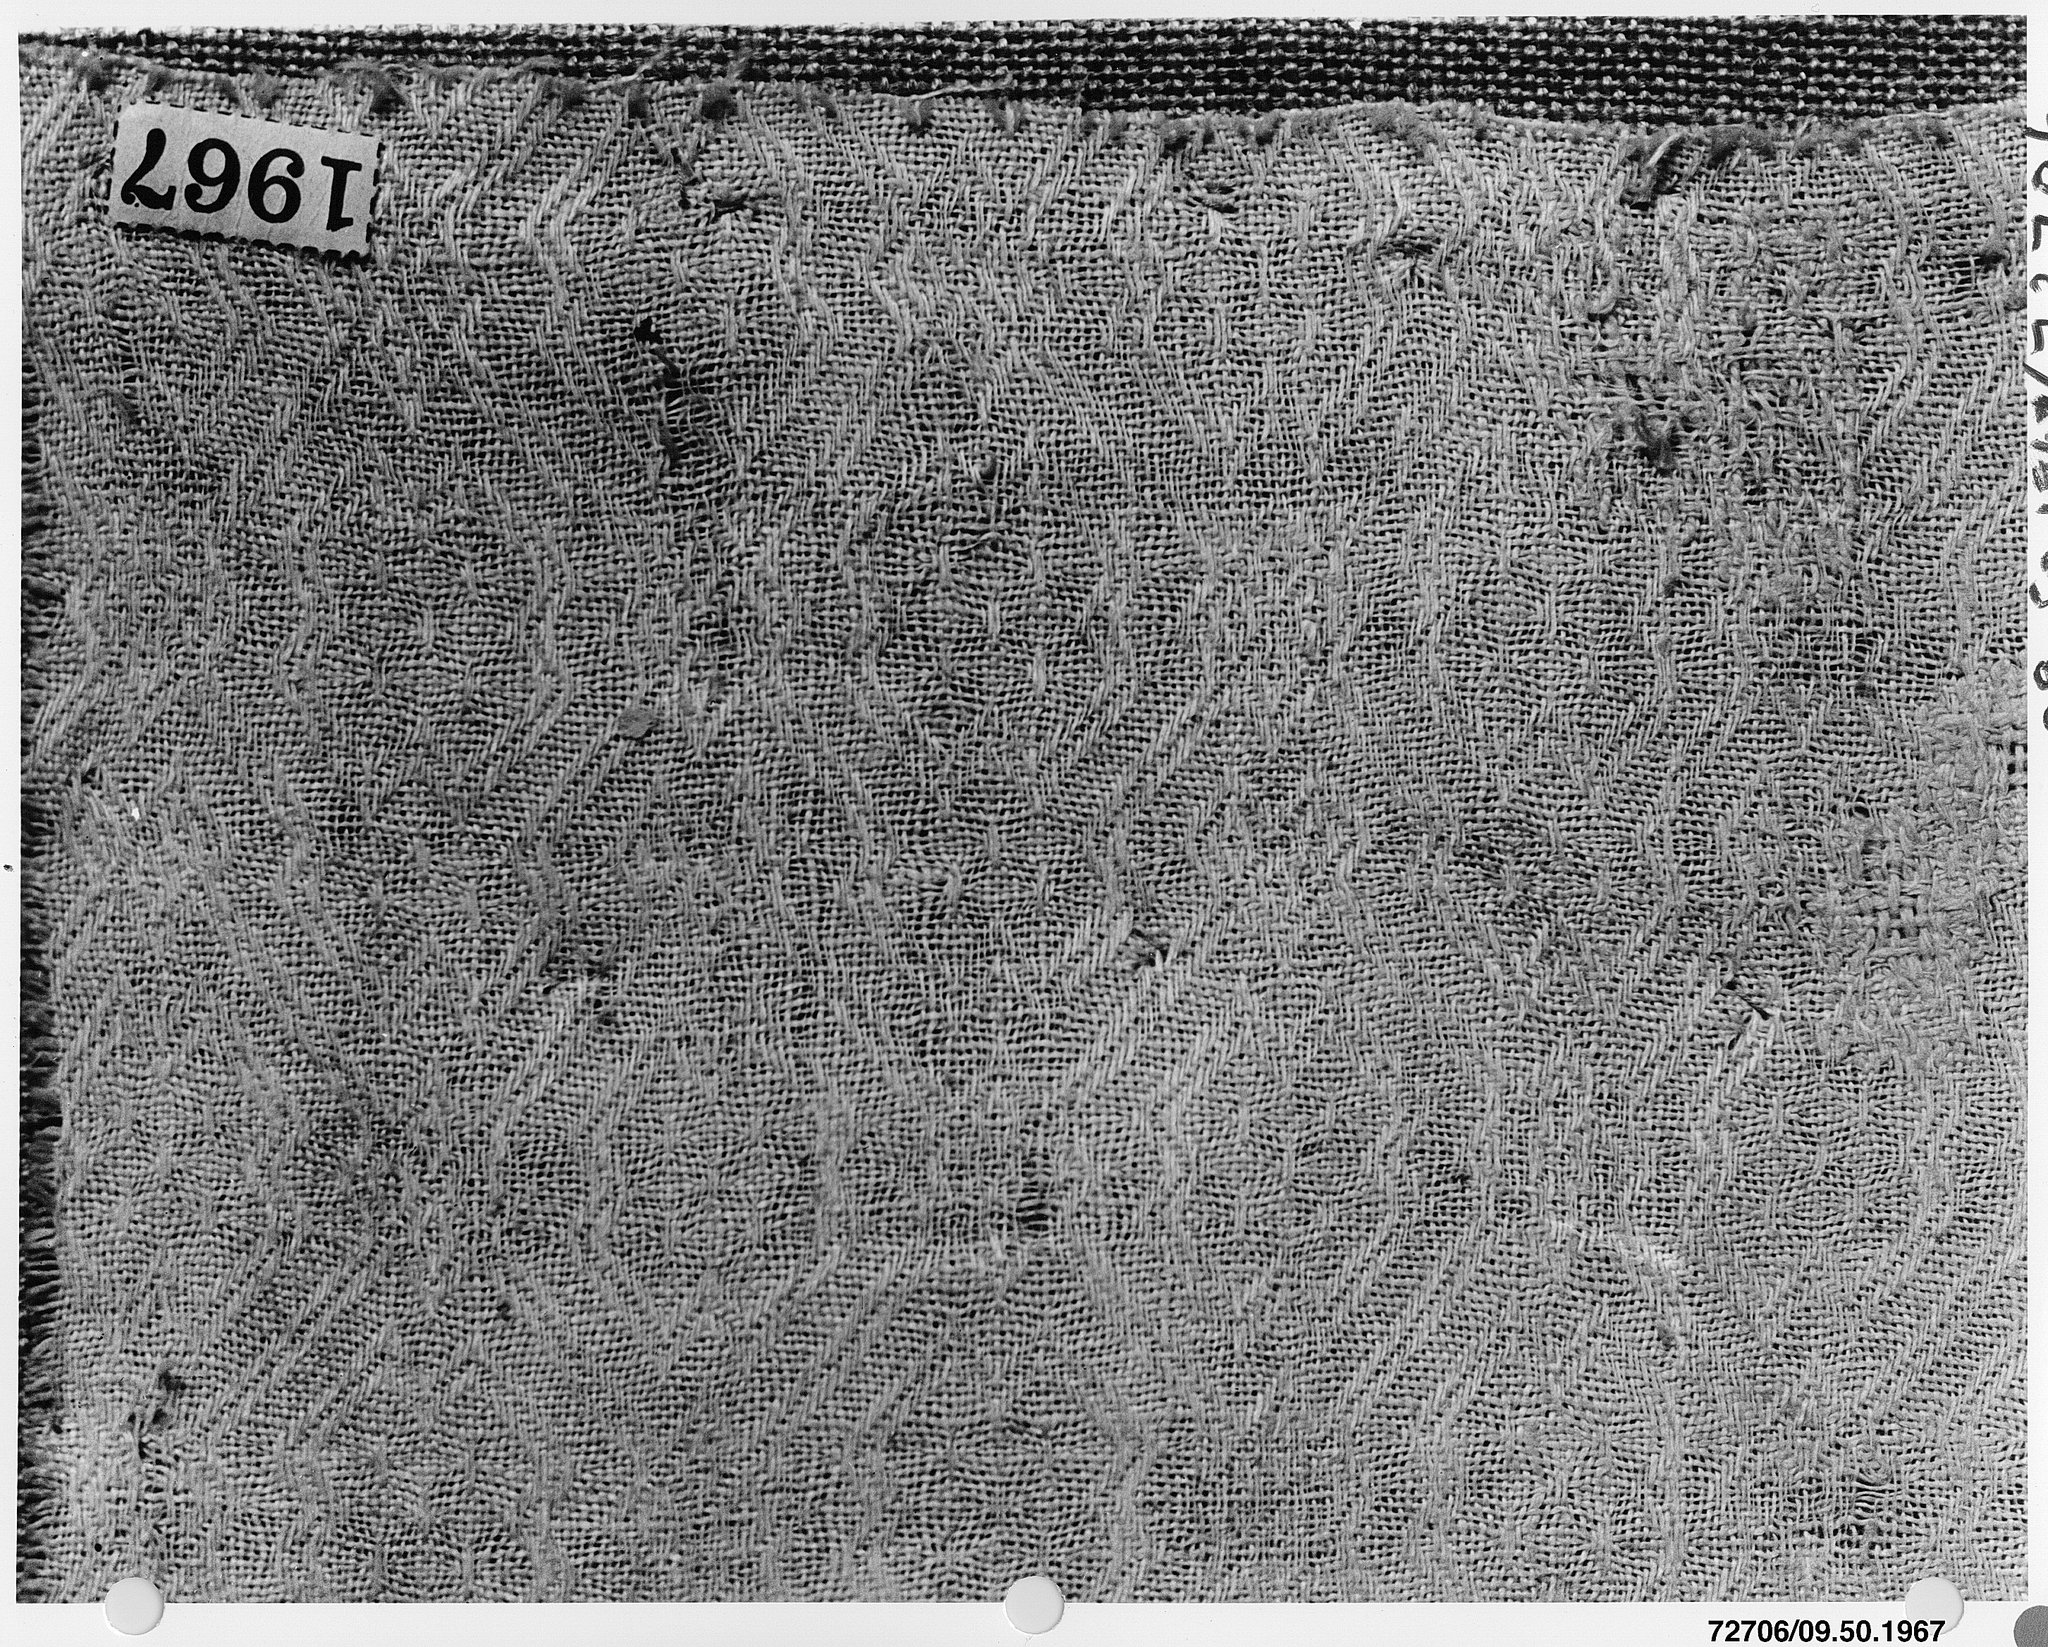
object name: fragment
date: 1701-1900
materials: linen